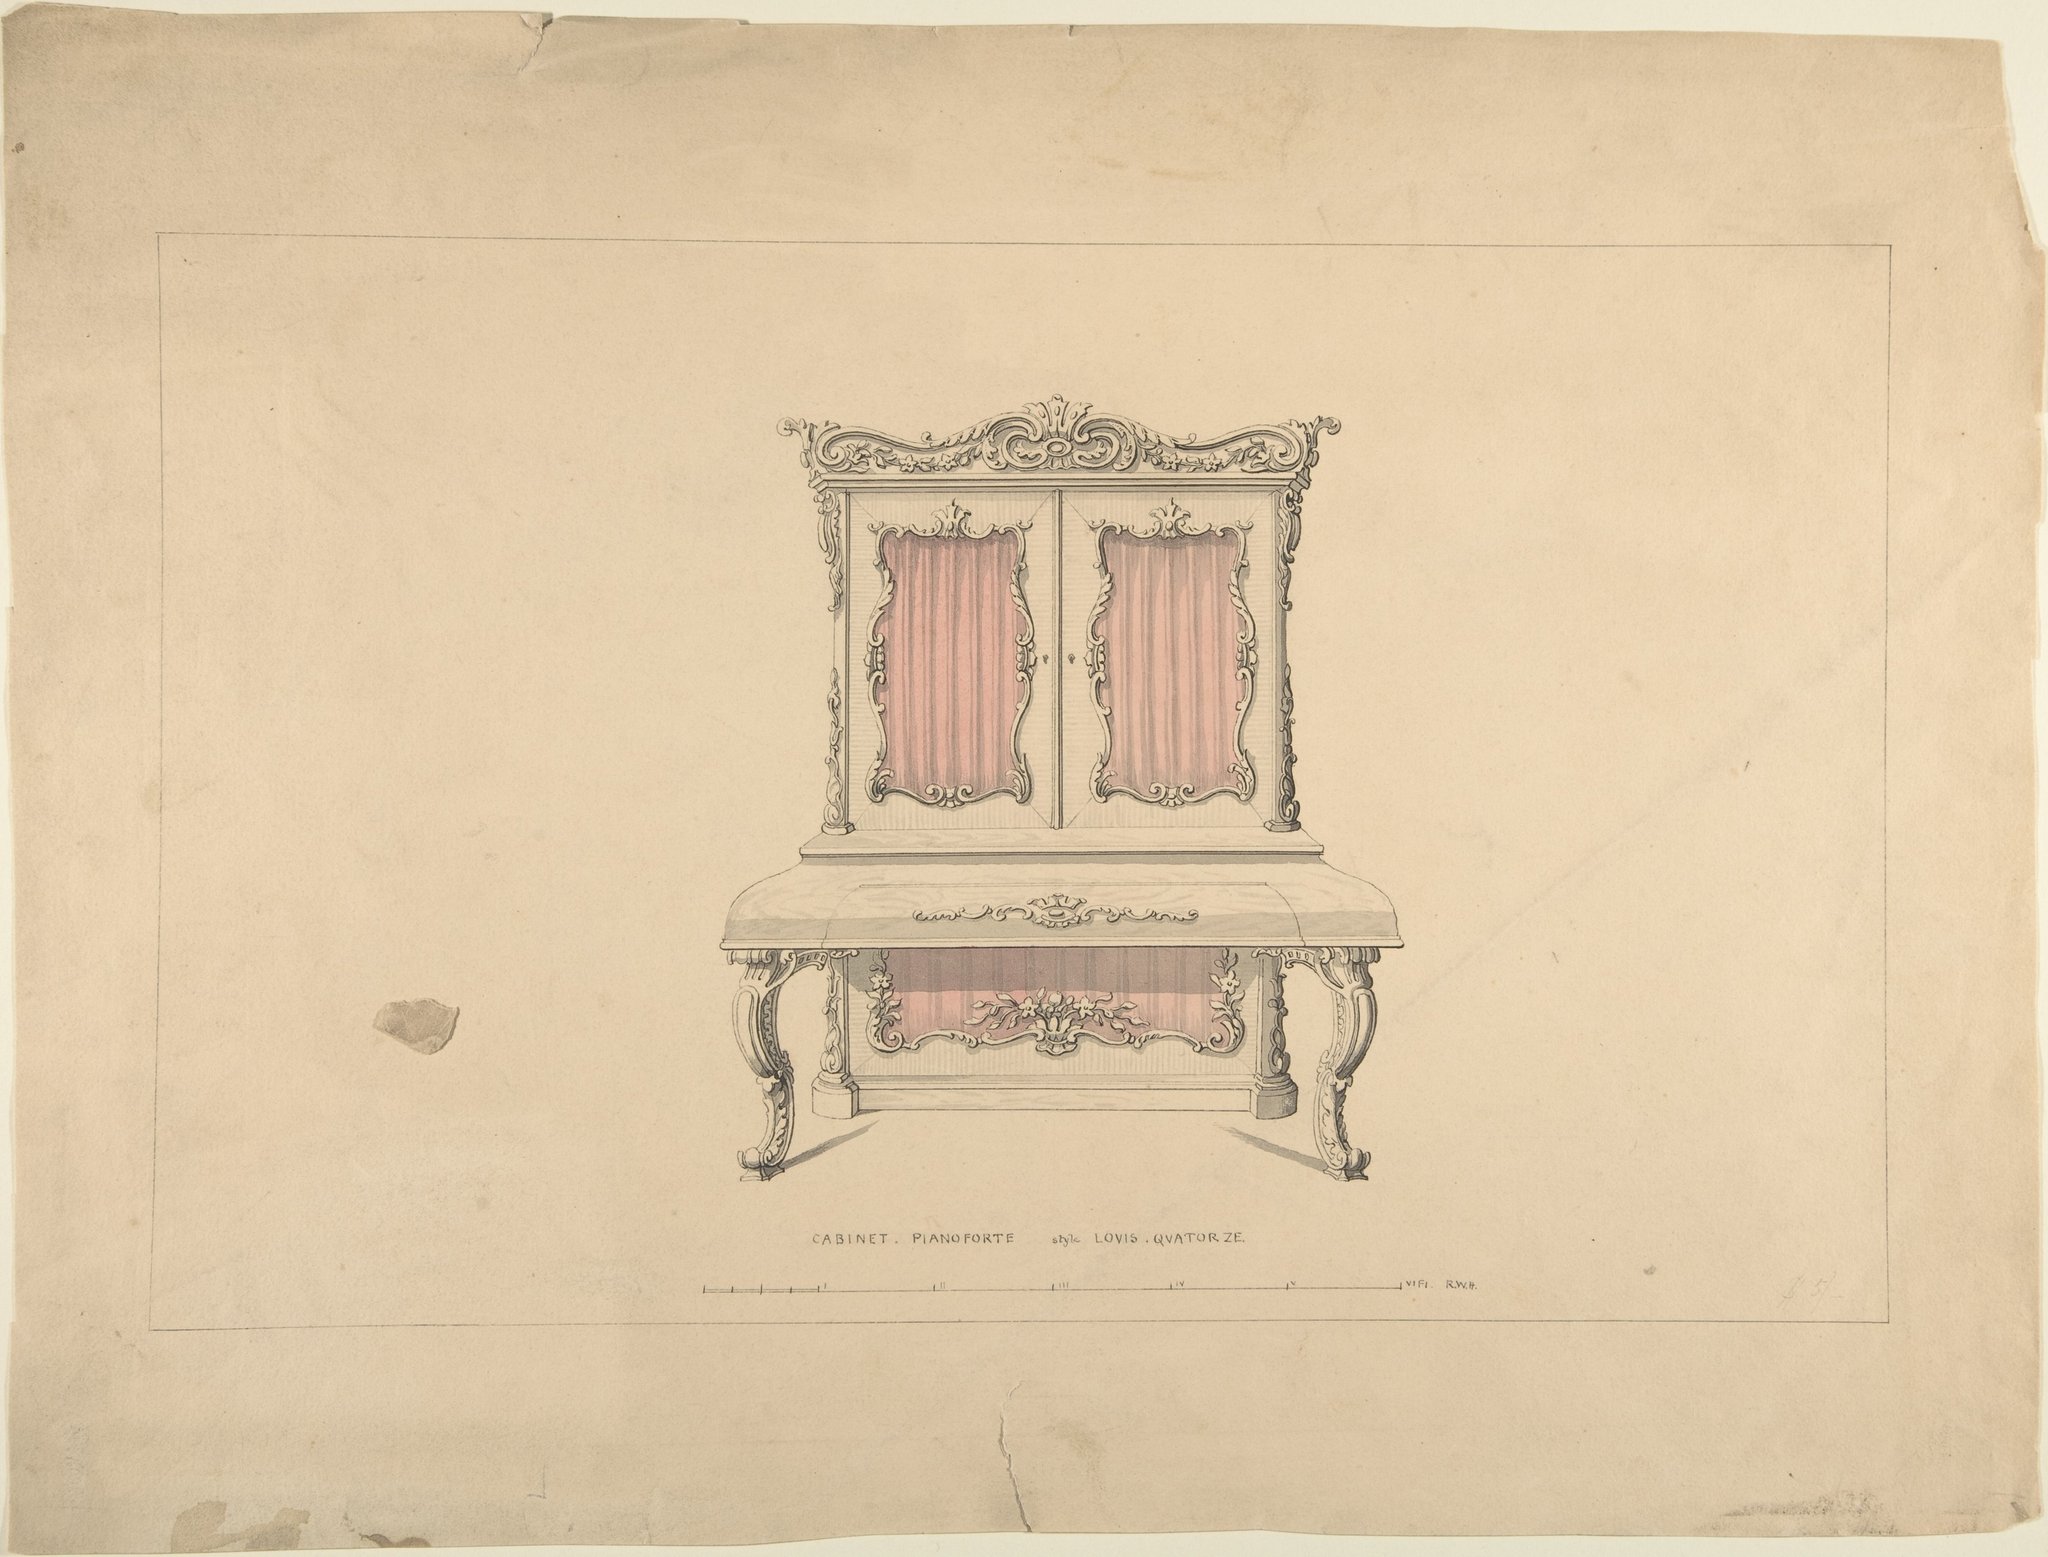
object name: drawing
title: Design for Cabinet Pianoforte, Louis Quatorze Style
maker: robert william hume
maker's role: artist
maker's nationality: british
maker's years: 1816-1904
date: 1835-1900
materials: graphite, ink, watercolor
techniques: pen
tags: cabinets